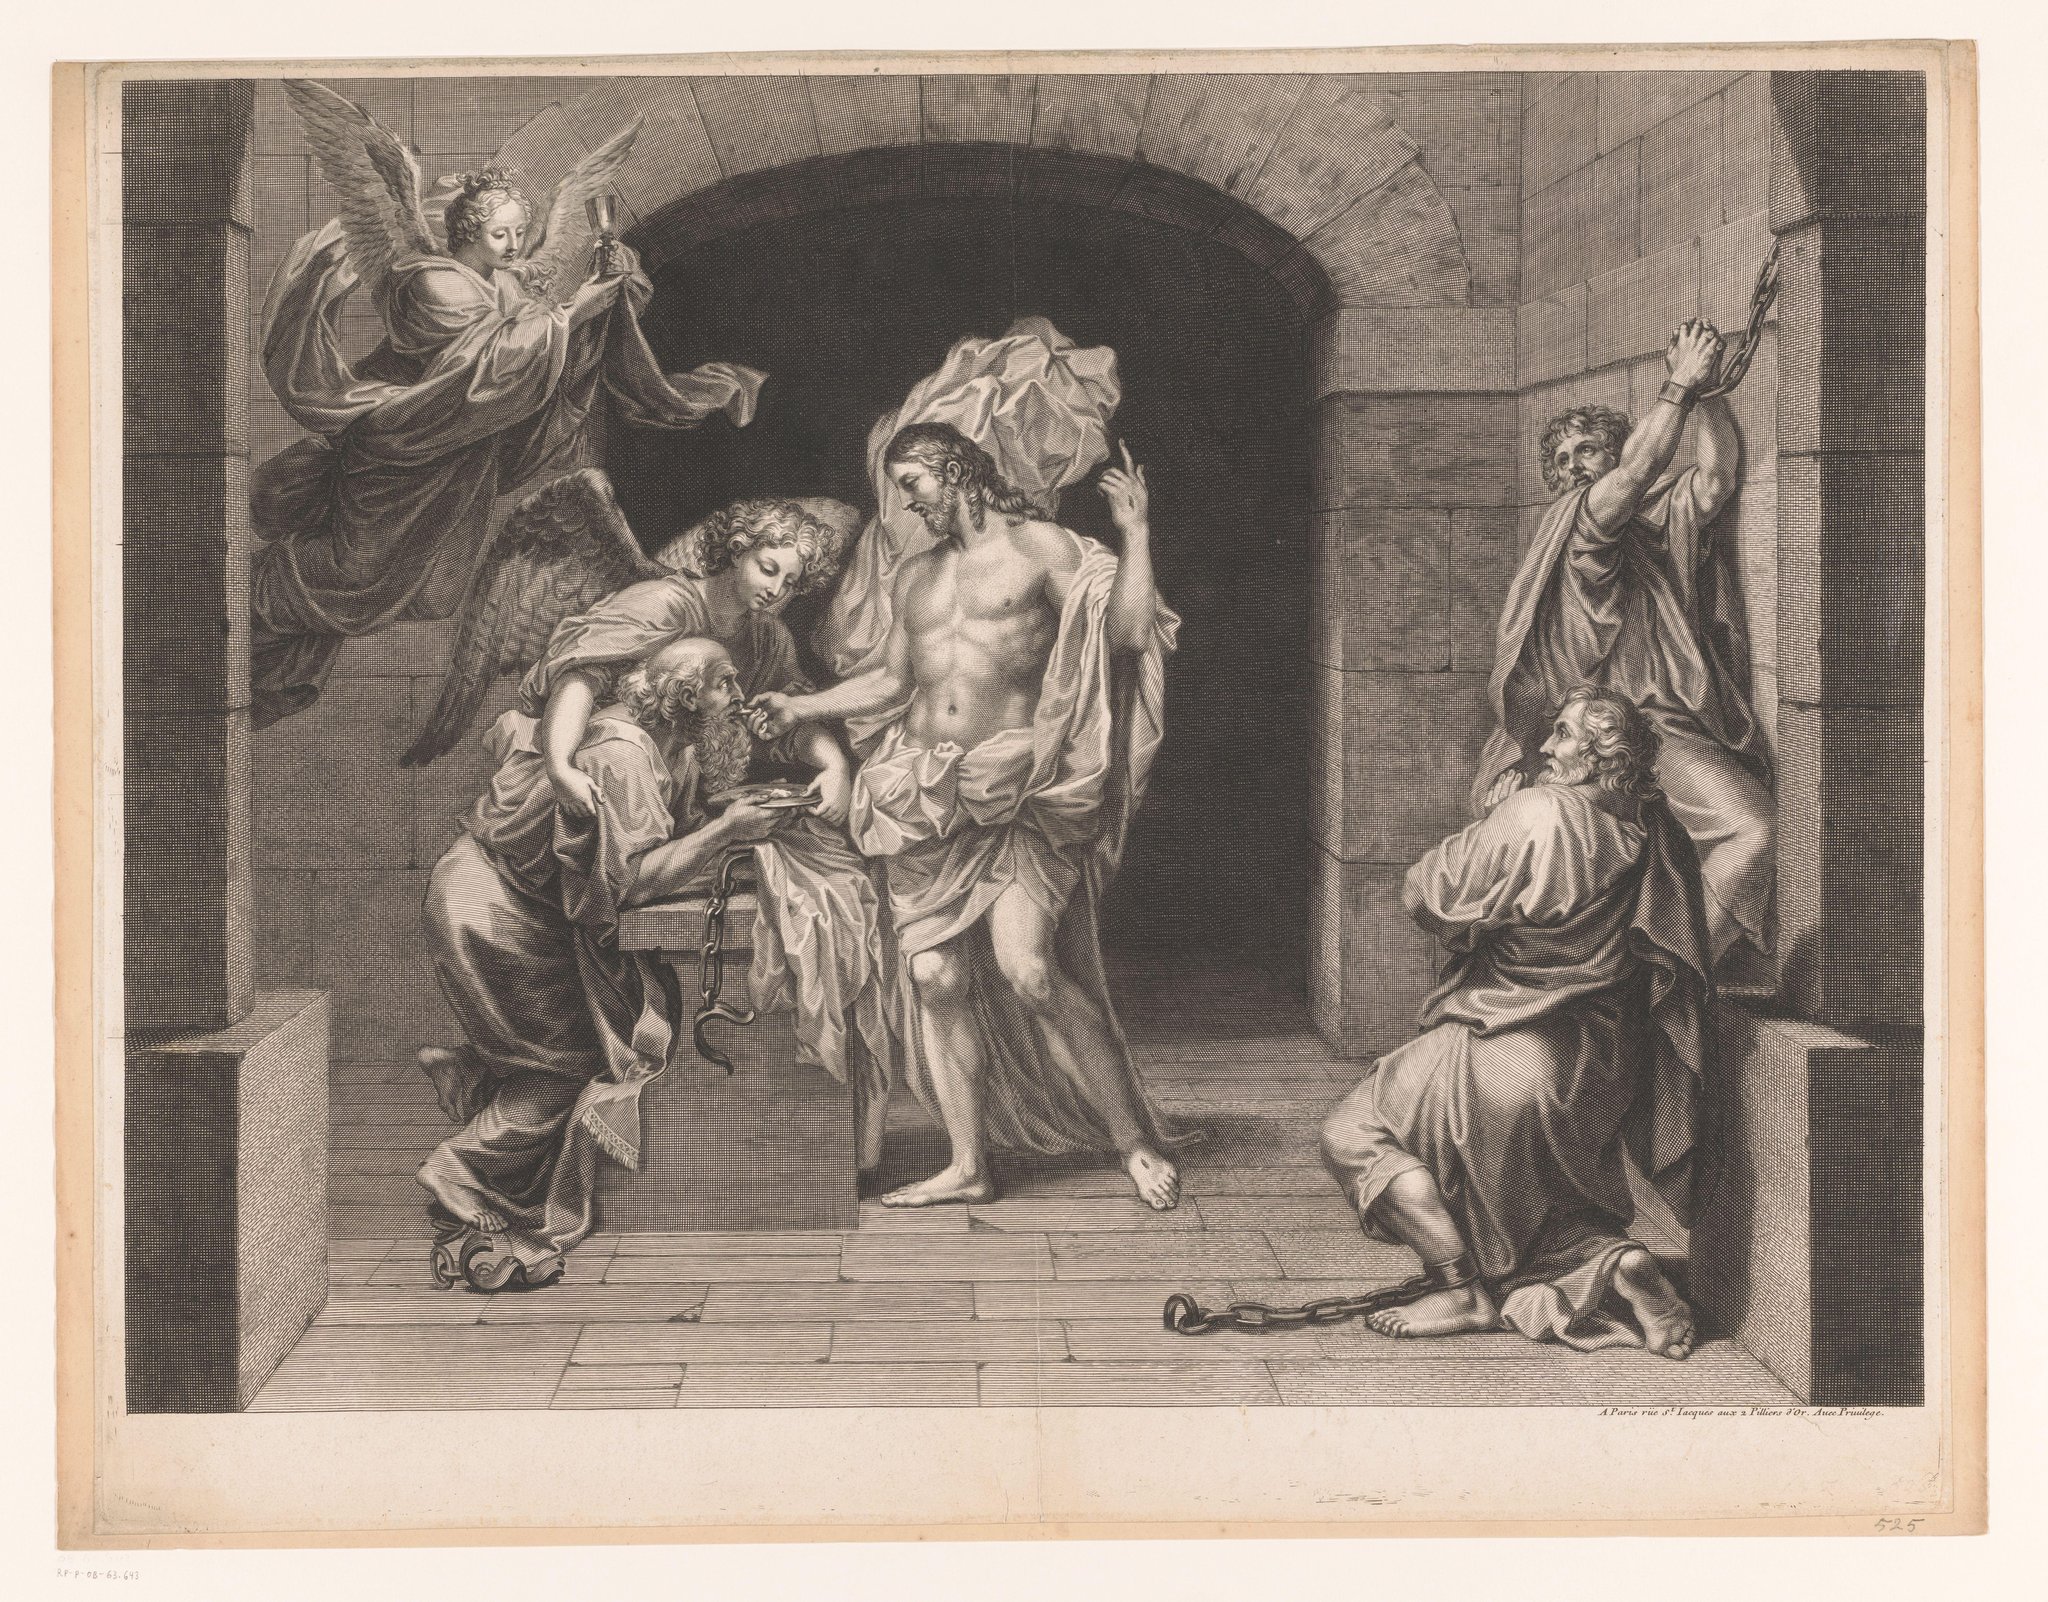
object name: print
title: Christus verschijnt aan Marcus in de gevangenis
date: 1600-1699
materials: paper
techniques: engraving, etching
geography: paris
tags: christ appears to st. mark in prison (+ angel(s))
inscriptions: collector's mark: Lugt 240